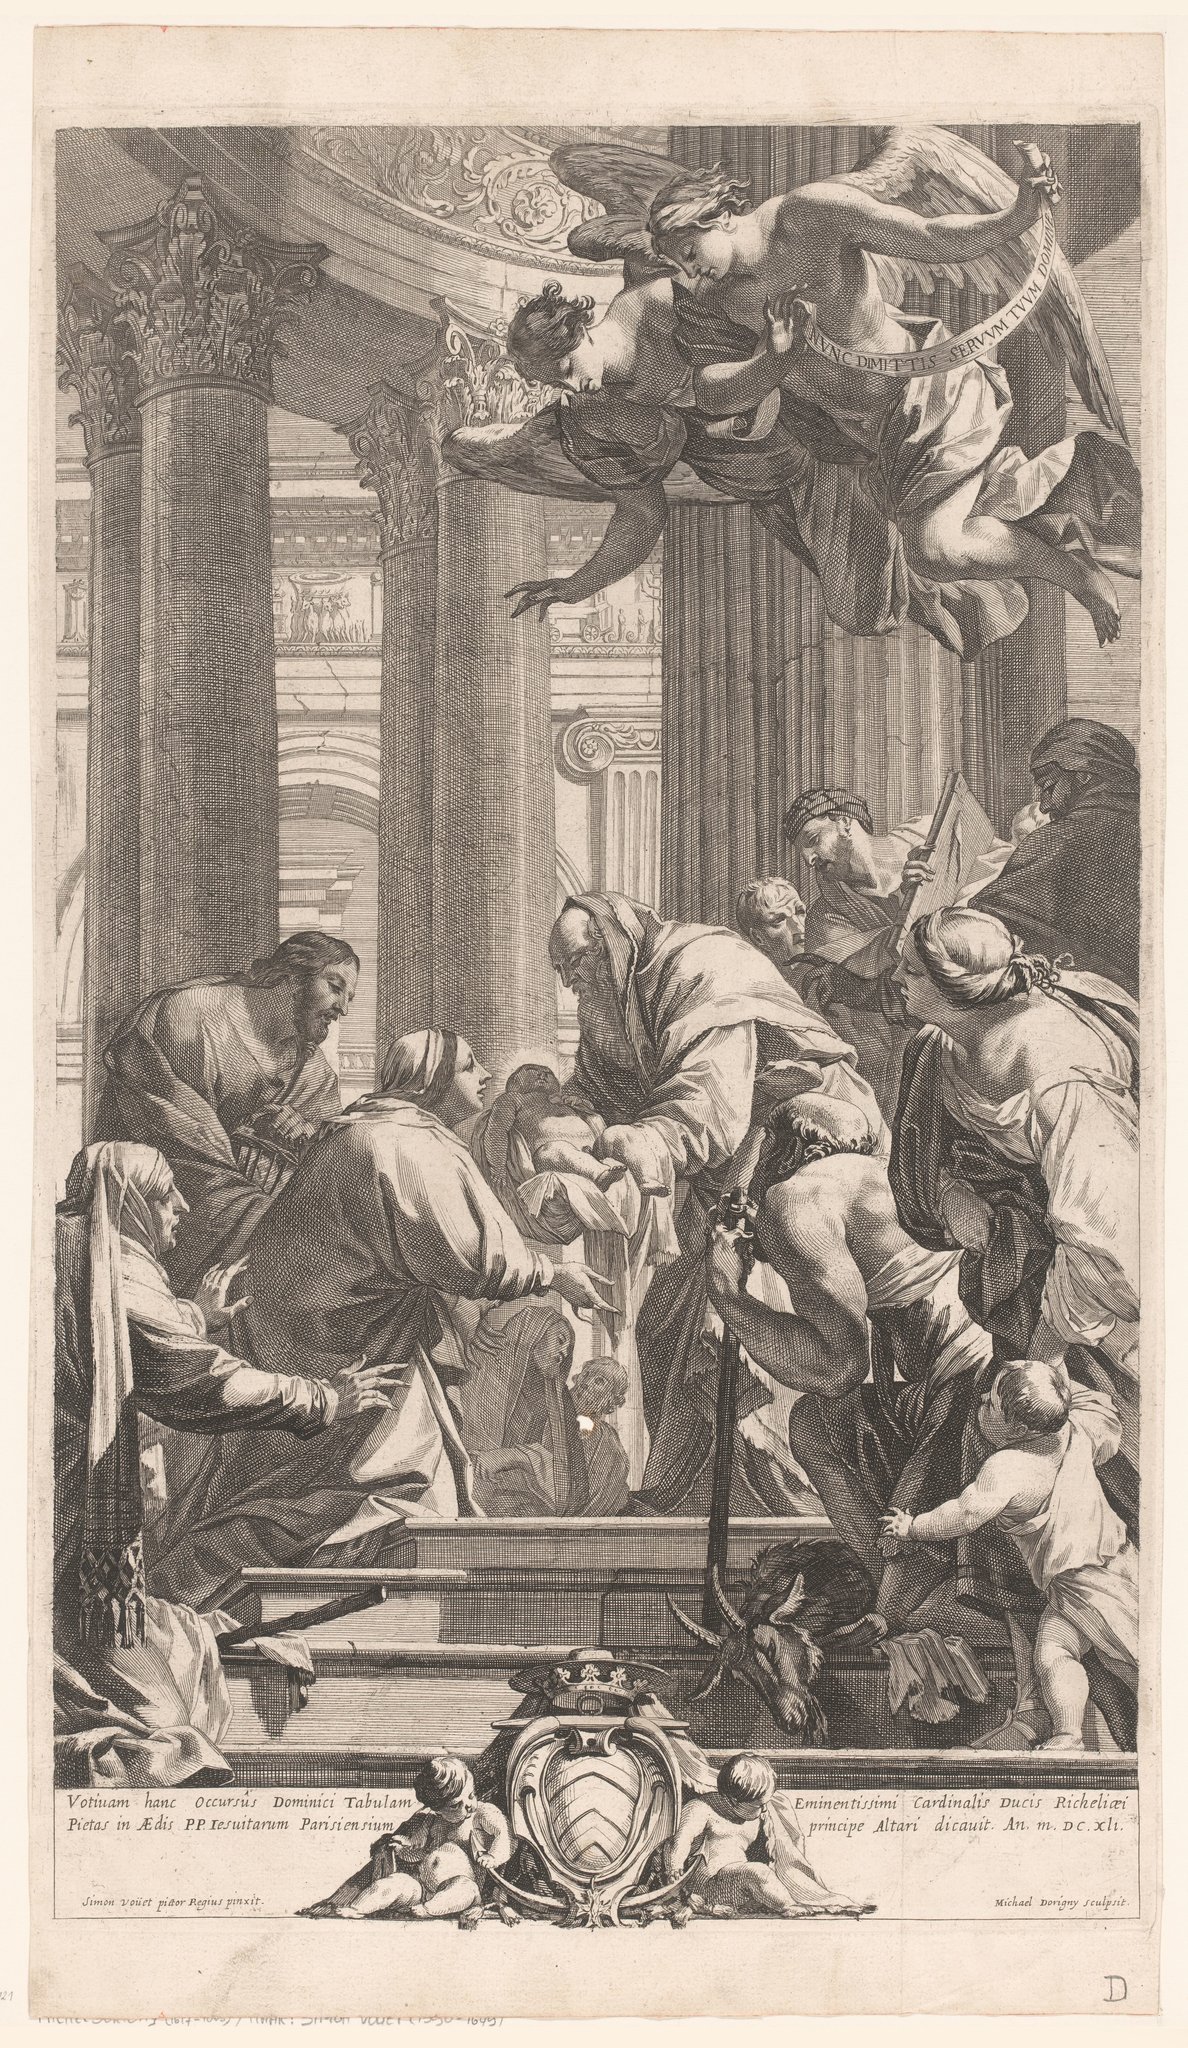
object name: print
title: Presentatie in de tempel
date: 1641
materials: paper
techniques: engraving, etching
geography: france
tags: presentation of the christ-child in the temple, usually simeon (and anna) present (luke 2:22-39)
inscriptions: collector's mark: Lugt 2228